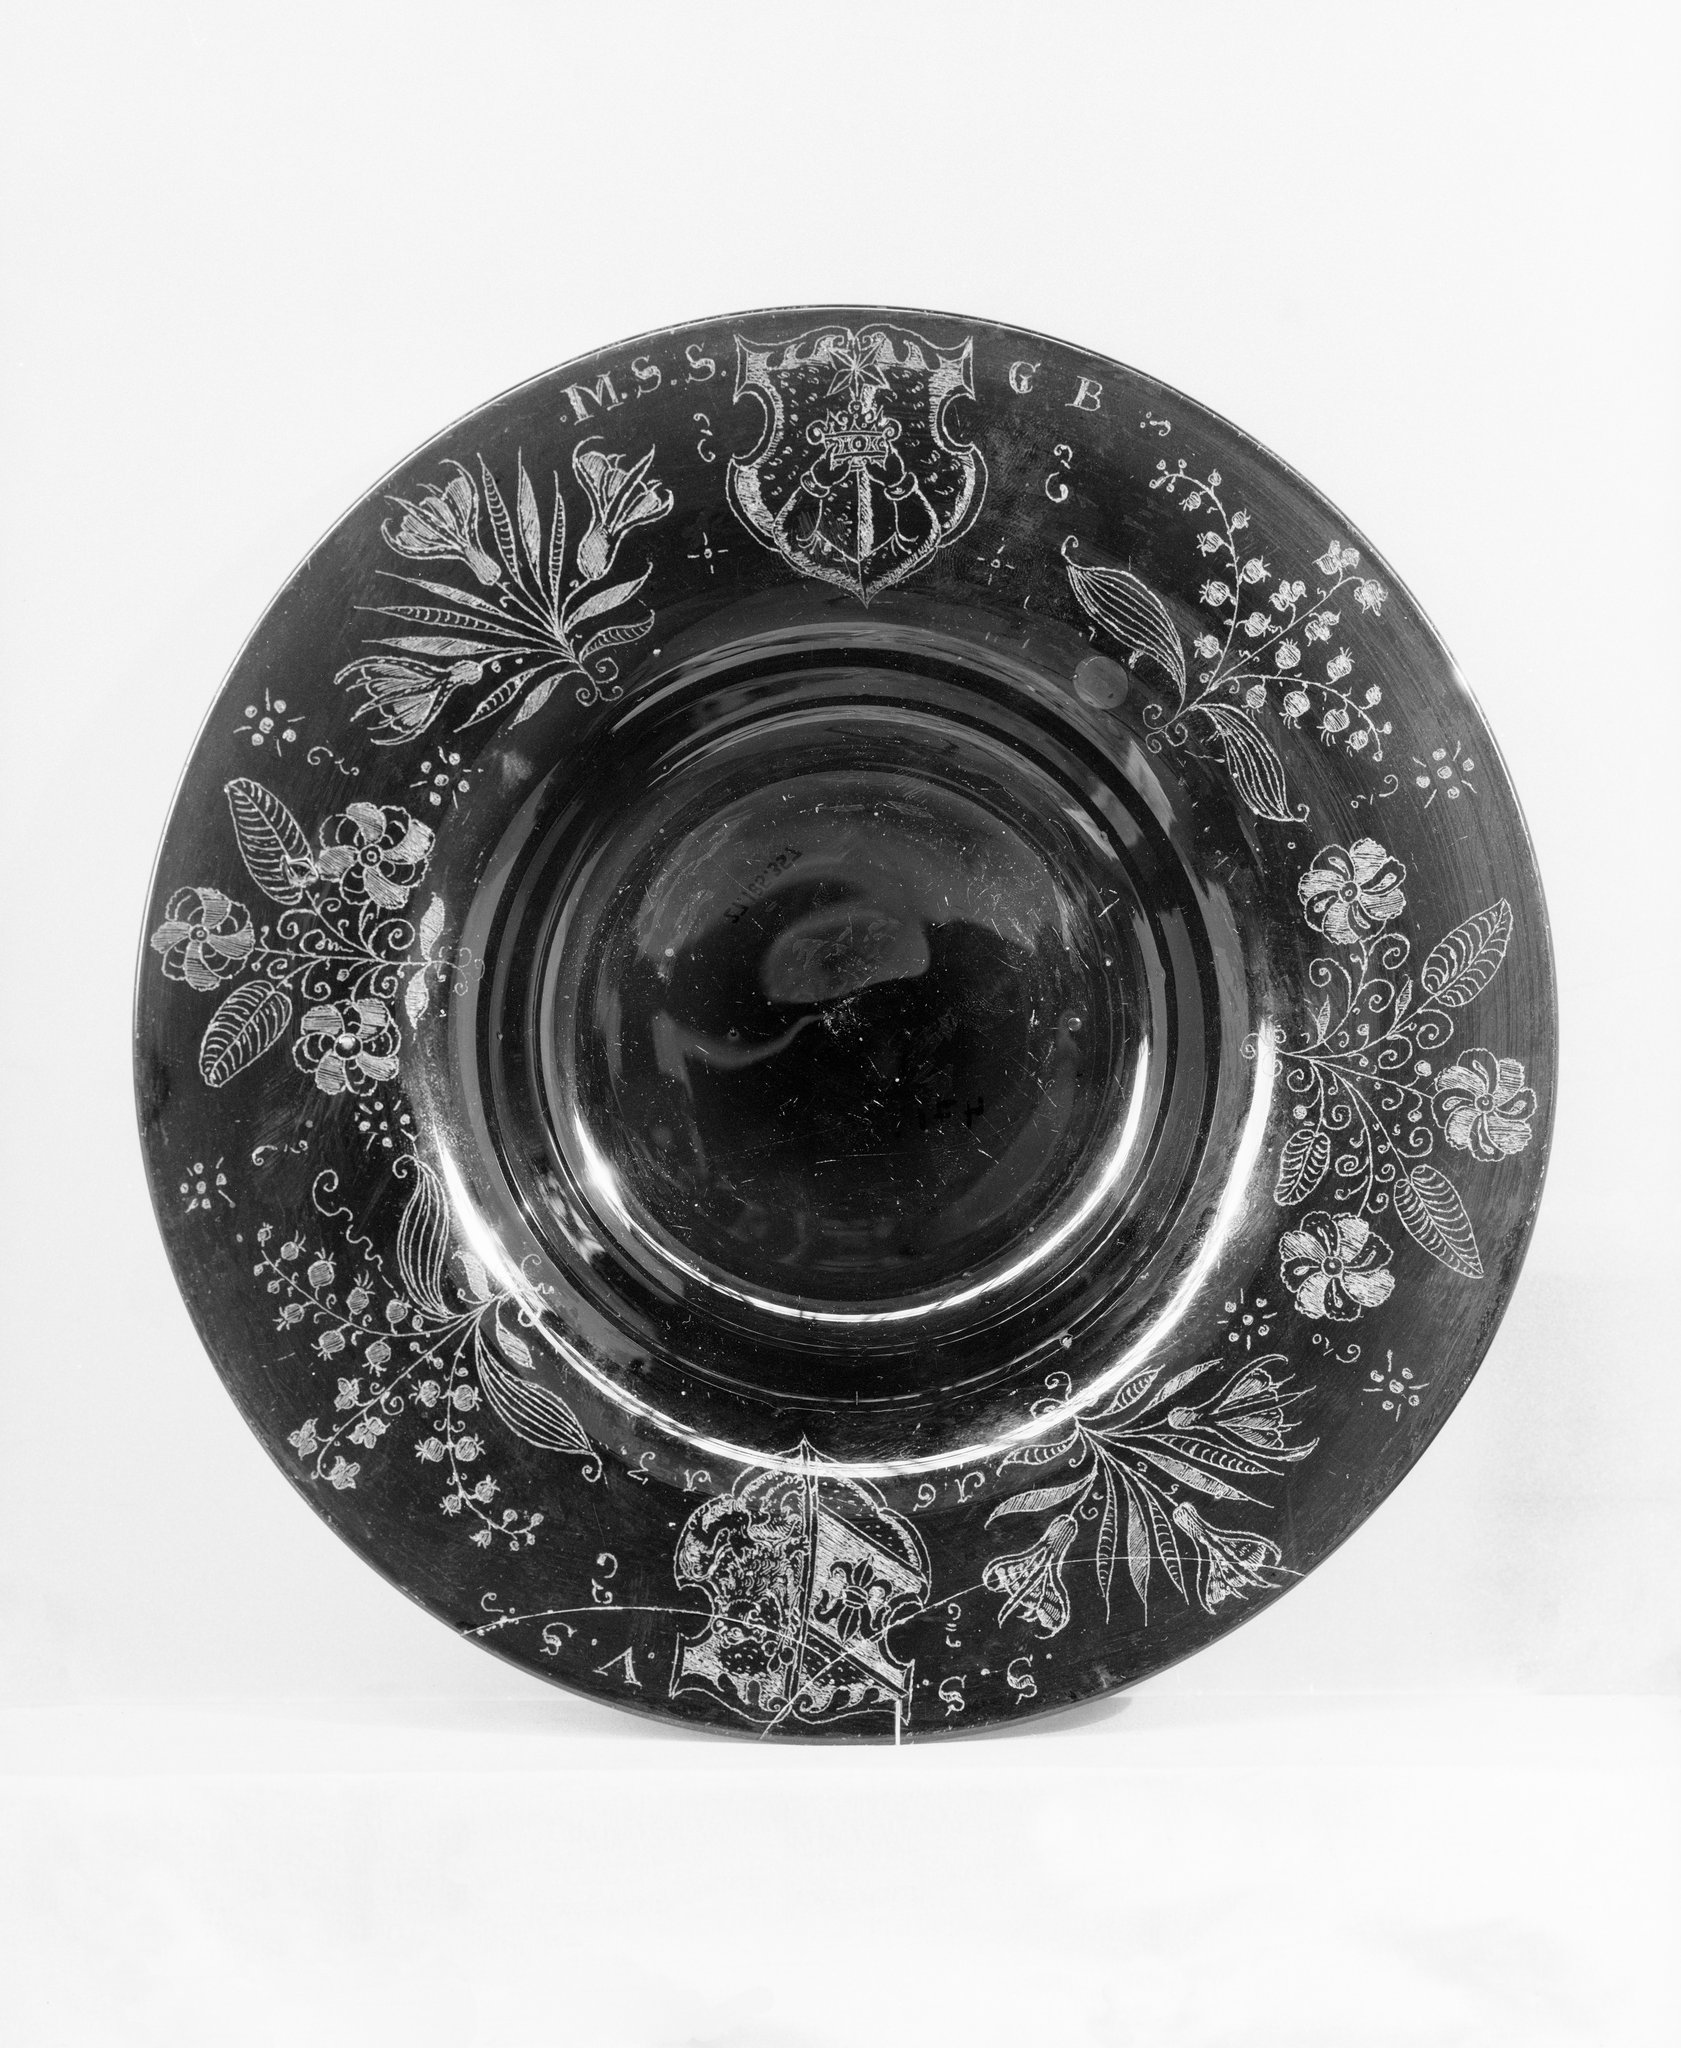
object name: dish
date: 1613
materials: glass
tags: flowers,insignia